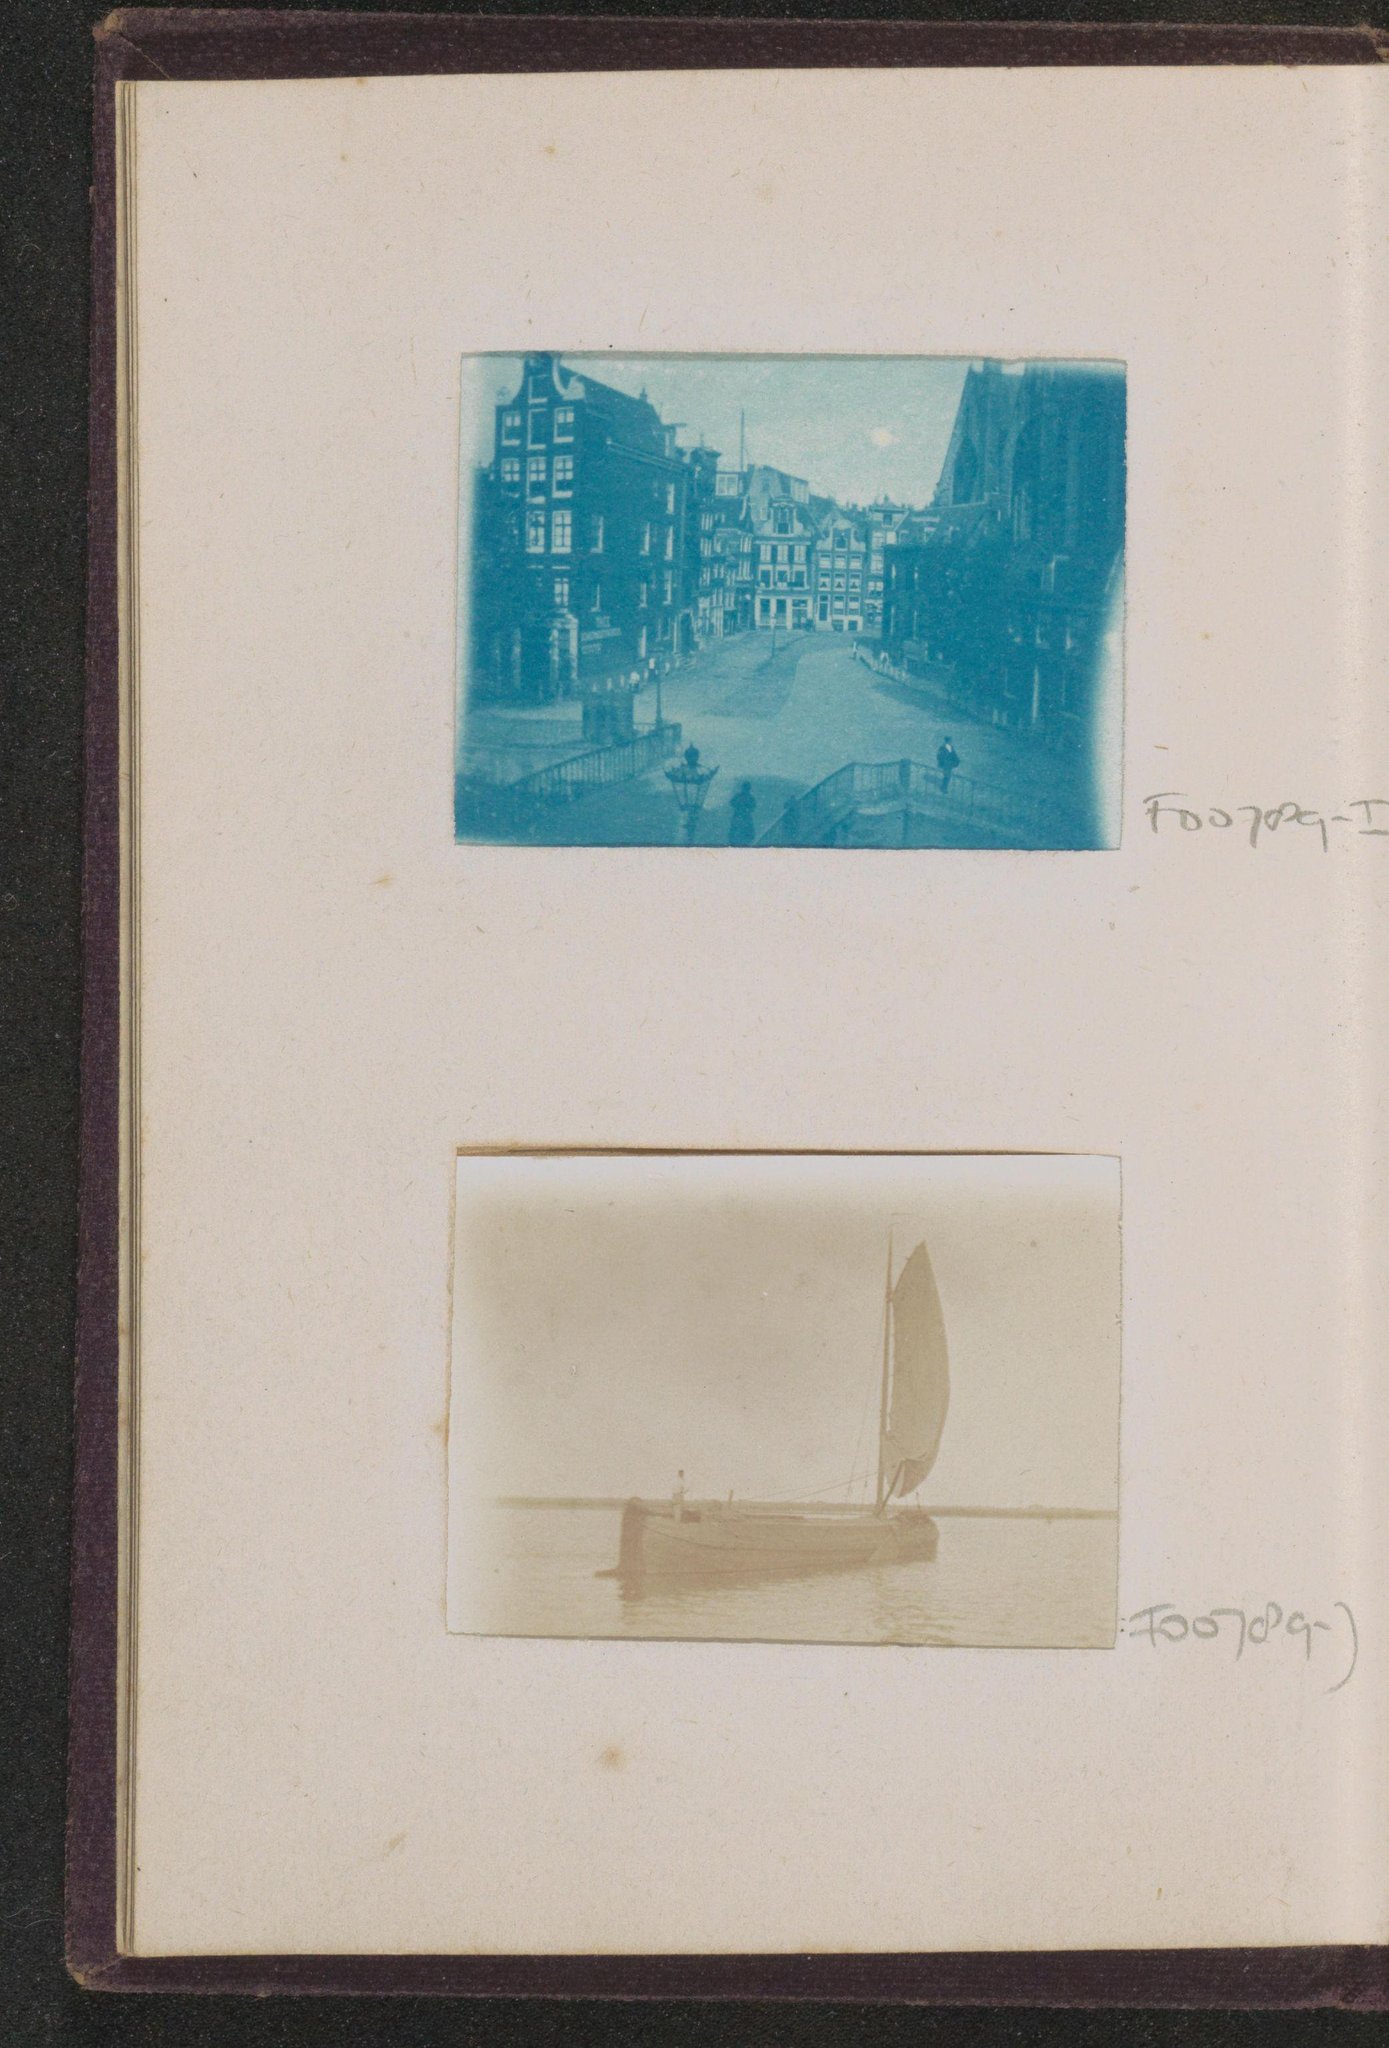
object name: contact print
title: Zeilschip op een water, vermoedelijk in Nederland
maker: Anonymous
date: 1880-1900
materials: paper, photographic support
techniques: collodion silver print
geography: netherlands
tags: sailing-ship, sailing-boat, netherlands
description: Onderdeel van Fotoalbum met 35 foto's van Amsterdam, personen en dieren.